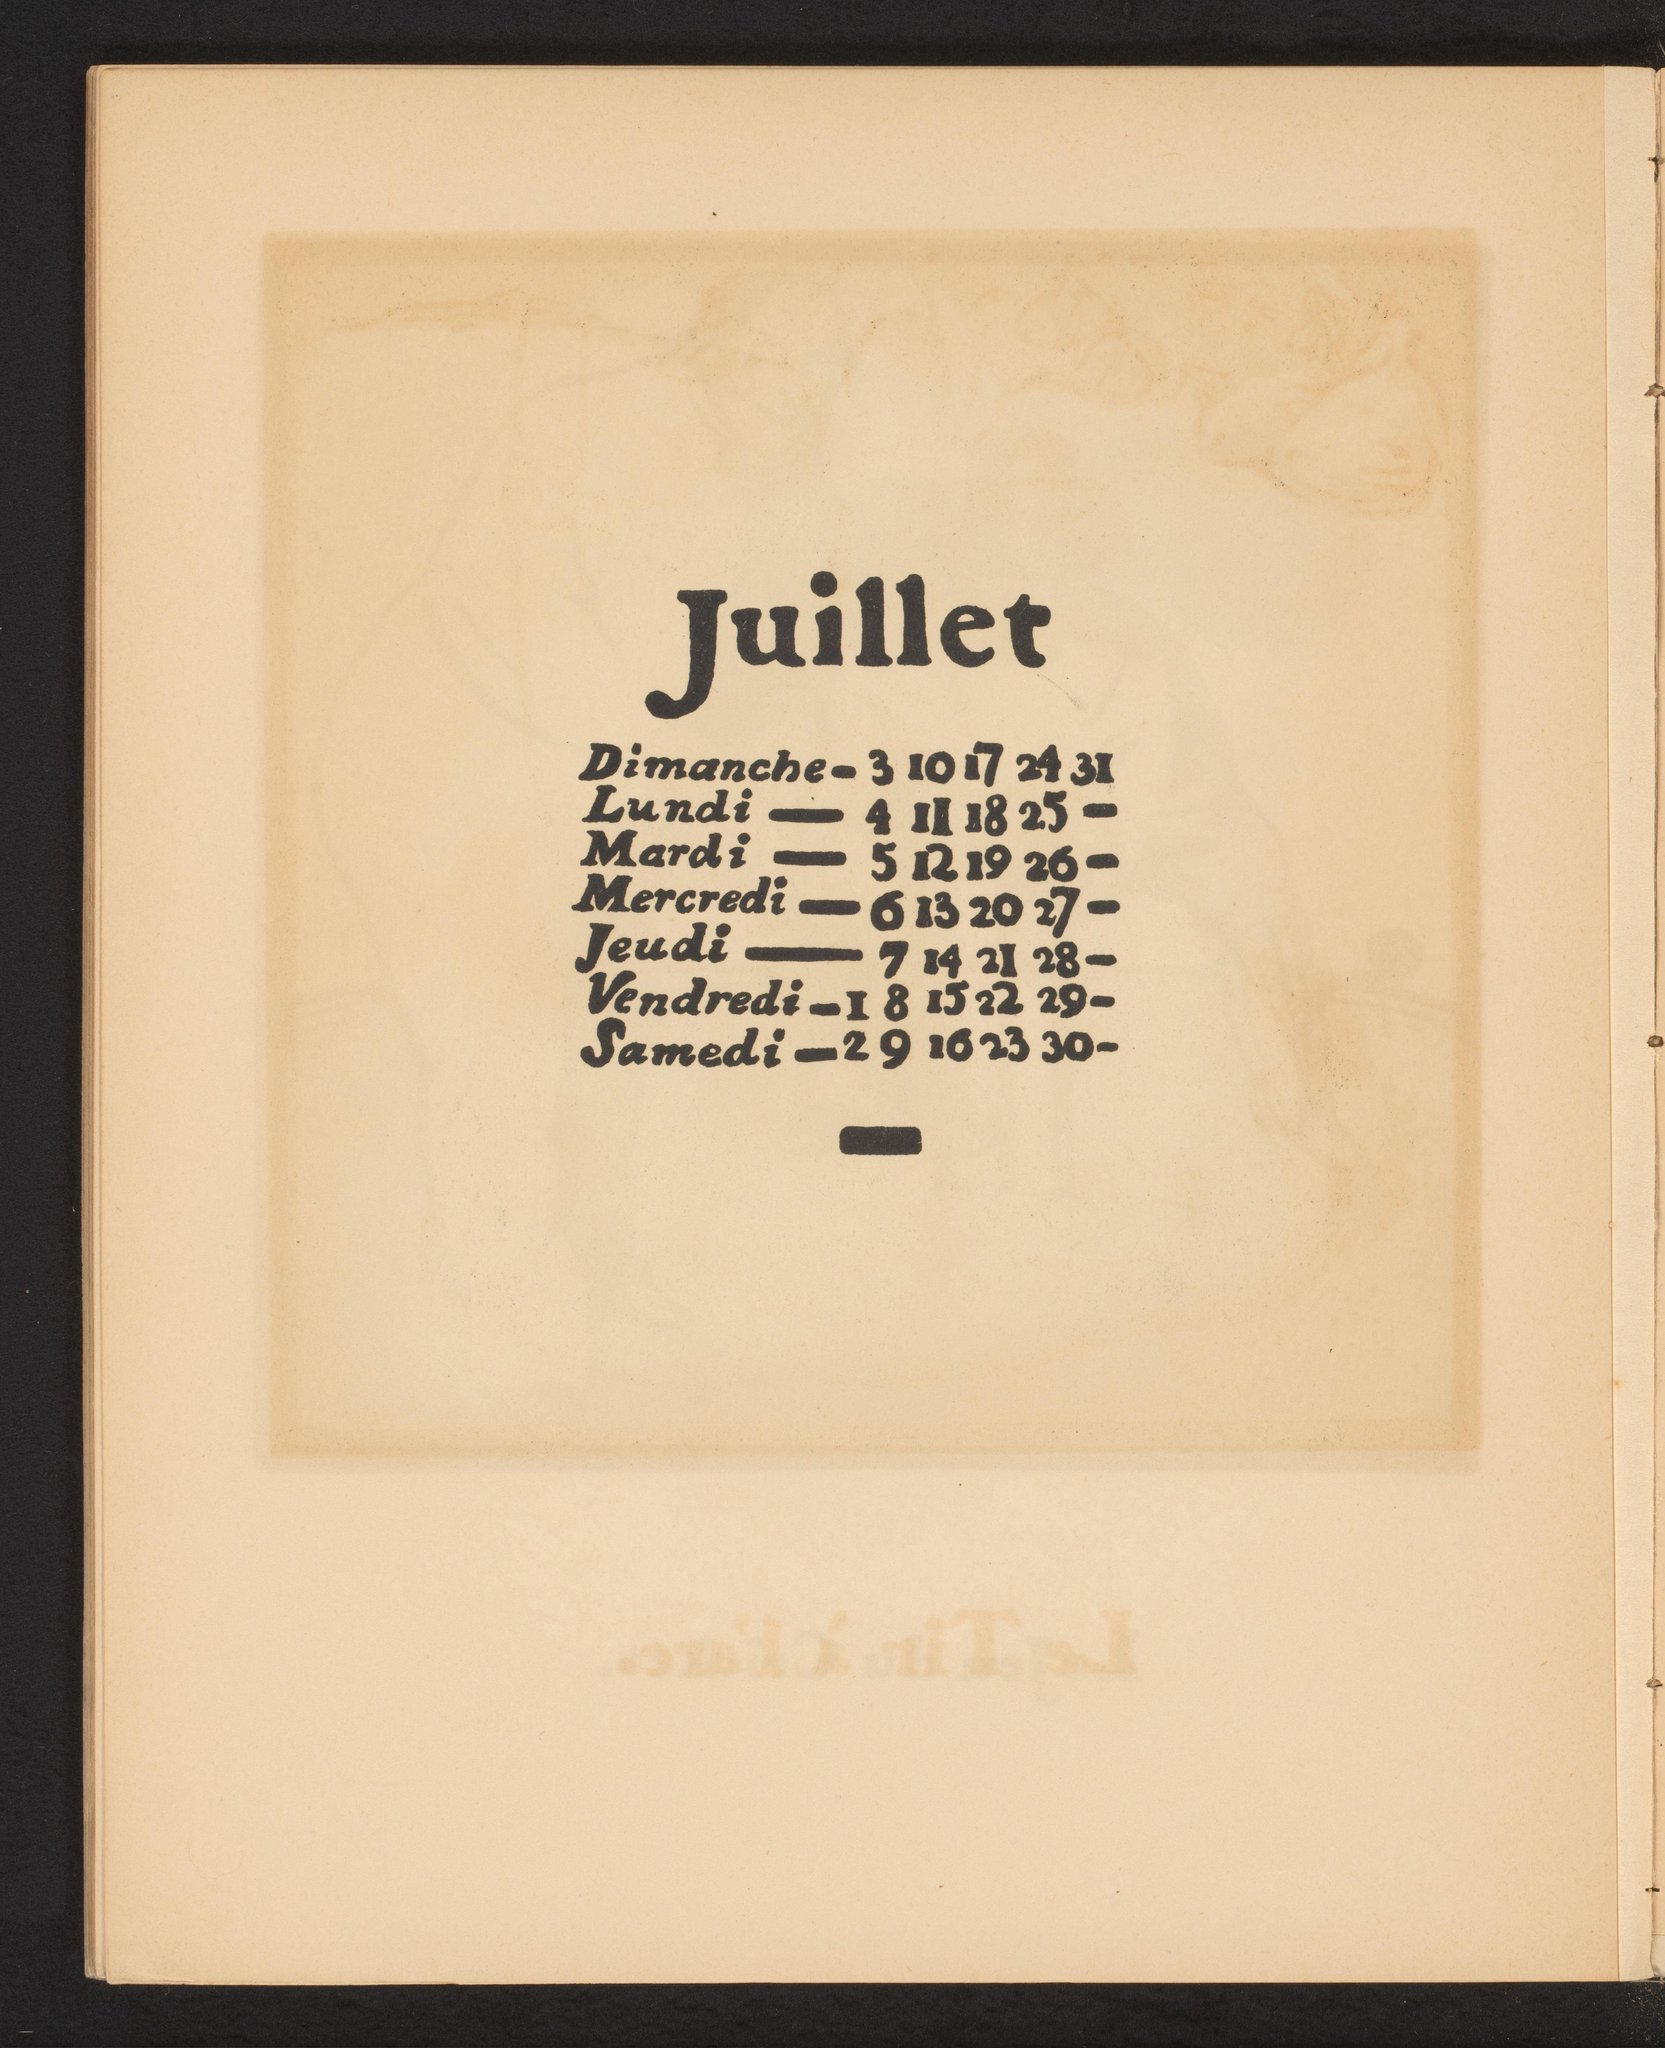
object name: calendar leaf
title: Almanach de douze Sports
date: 1898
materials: paper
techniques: lithograph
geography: paris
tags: july ~ other concepts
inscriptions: : ‘Juillet/ Dimanche - 3 10 17 24 31/ Lundi - 4 11 18 (...)’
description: Kalendermaand bij de illustratie op het tegenoverliggende blad. Prent maakt deel uit van een boek.